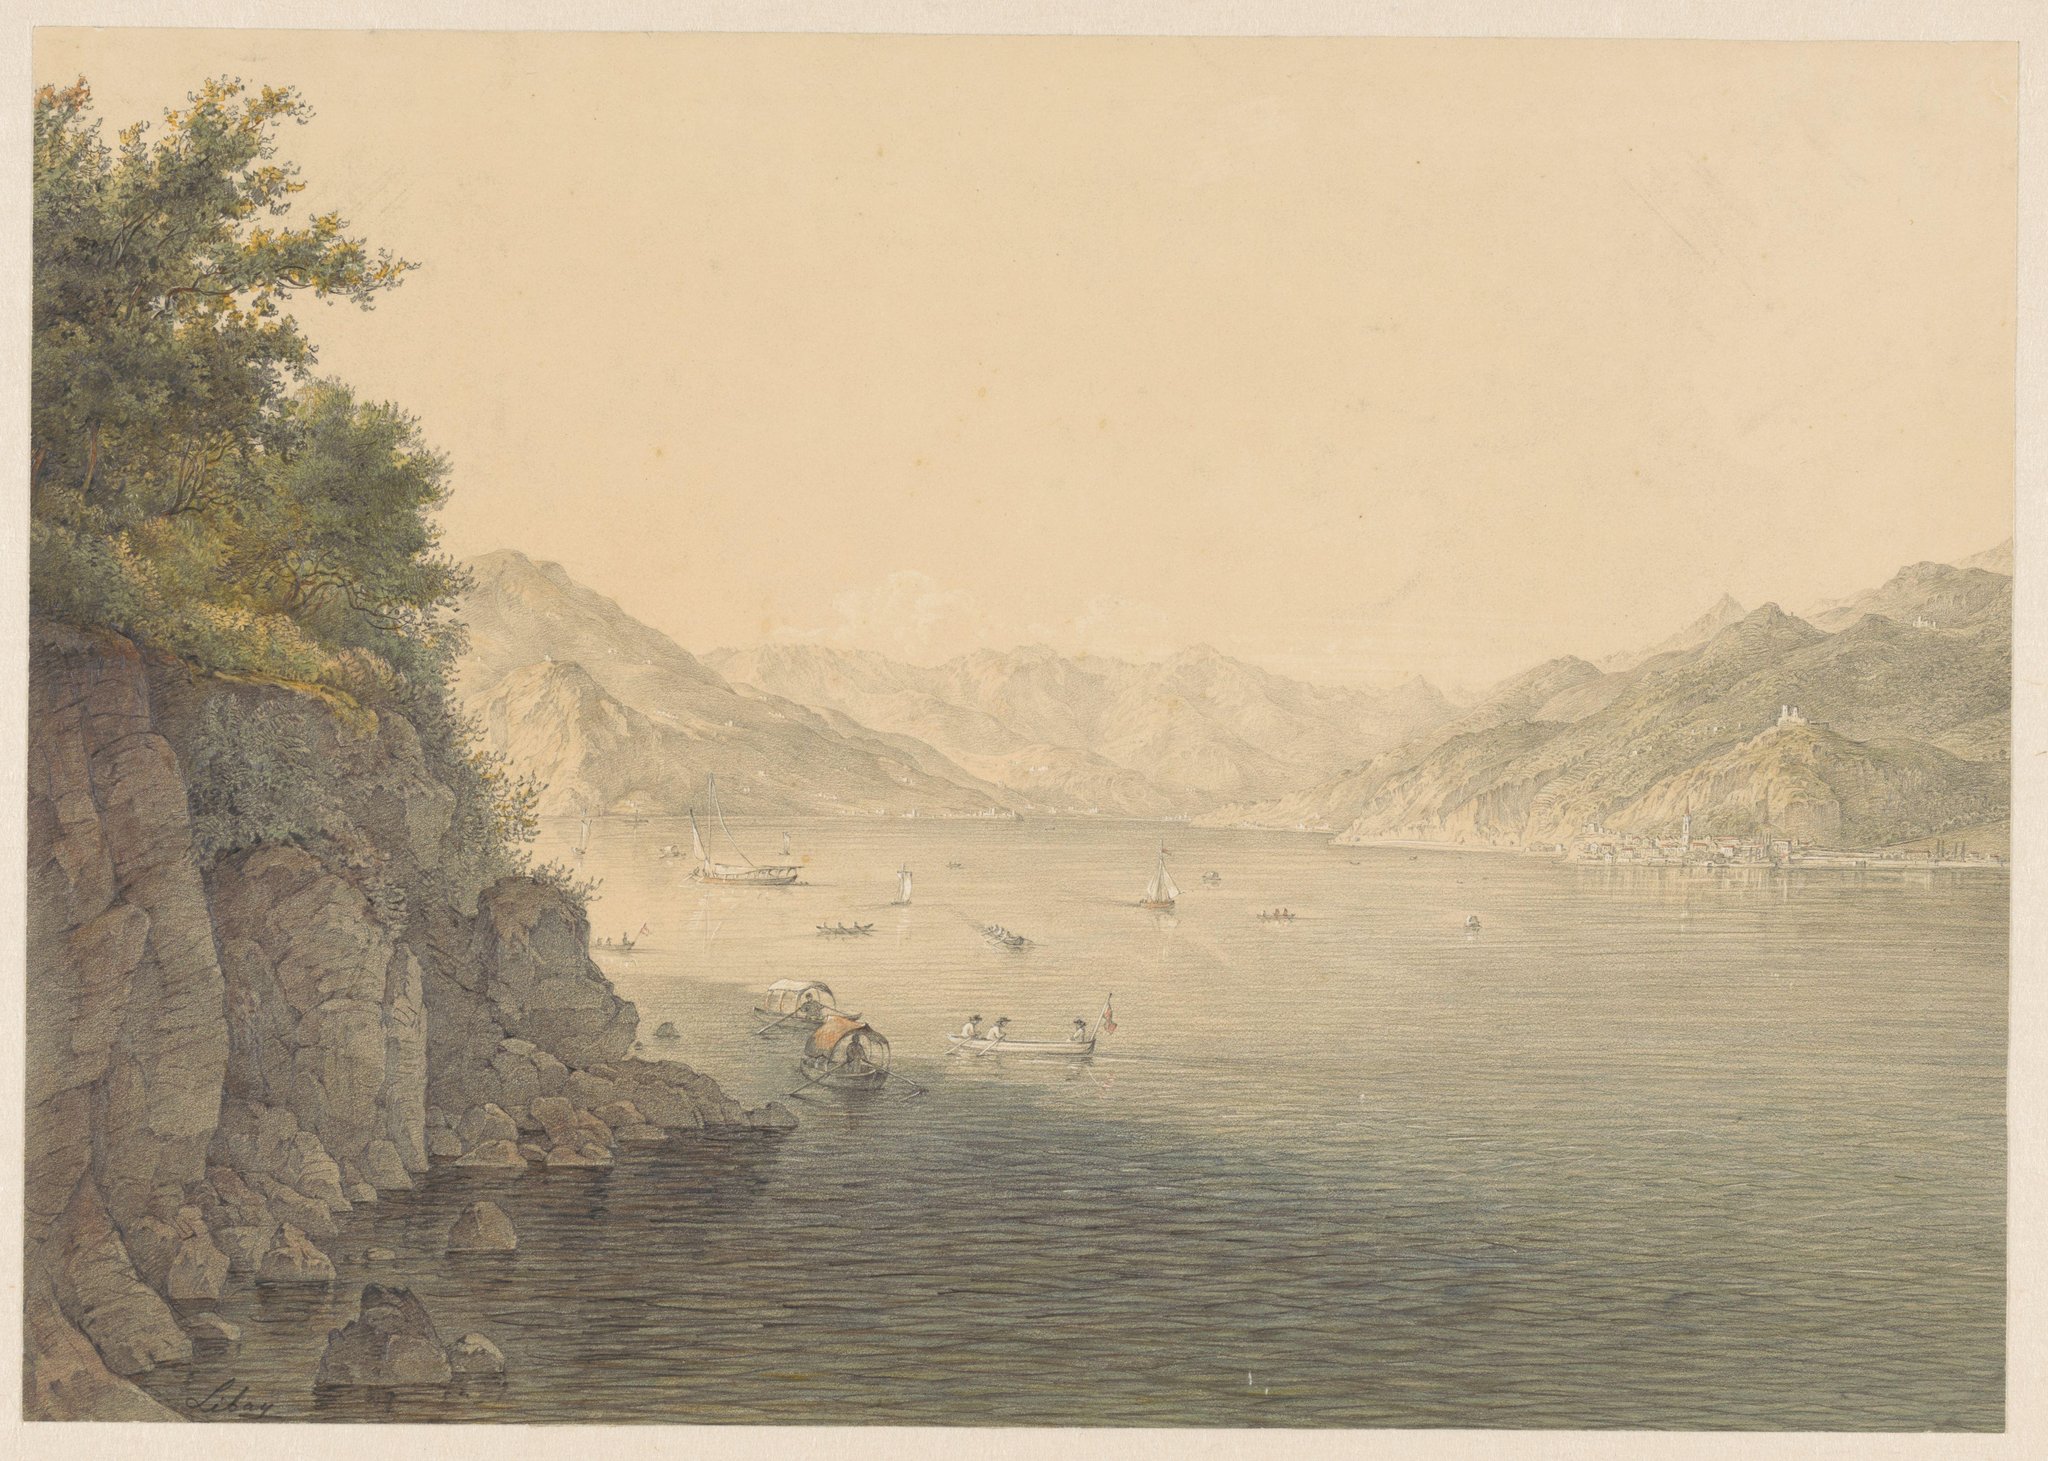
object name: drawing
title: Varenna aan het Comomeer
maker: karoly lajos libay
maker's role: draughtsman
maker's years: 1814-1888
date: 1824-1888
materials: cardboard, pencil, watercolor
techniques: brush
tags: lake, prospect of city, town panorama, silhouette of city (+ city(-scape) with figures, staffage)